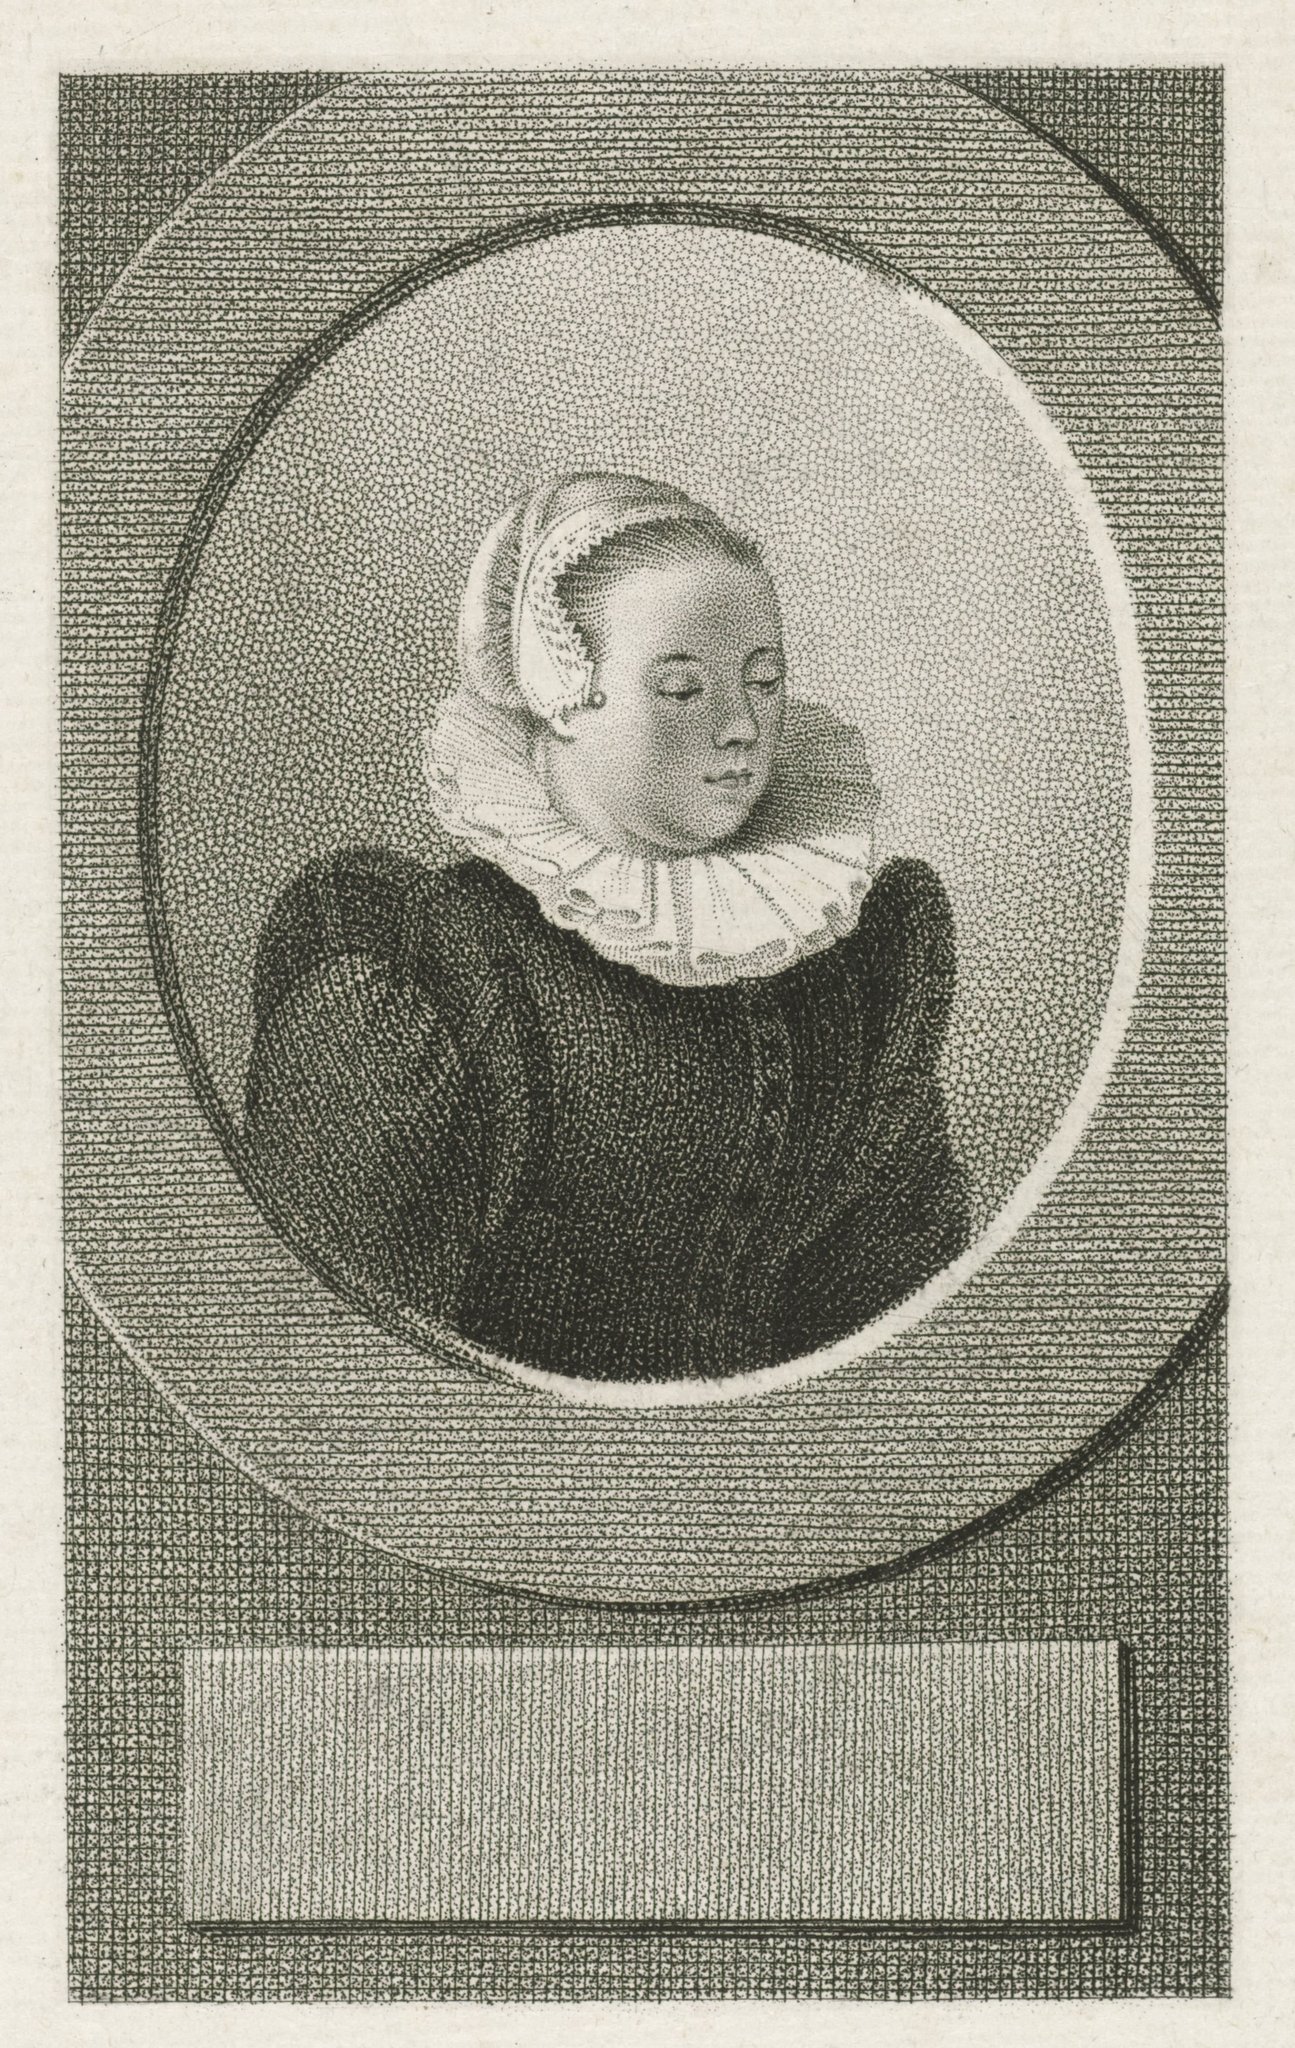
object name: print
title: Portret van een onbekende vrouw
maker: pieter van der meulen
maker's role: draughtsman, painter, print maker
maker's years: 1780-1858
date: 1790-1858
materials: paper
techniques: stippled etching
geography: amsterdam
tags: anna roemers visscher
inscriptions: collector's mark: Lugt 2228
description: Portret van Anna Roemers Visscher, dichteres en glasgraveur.